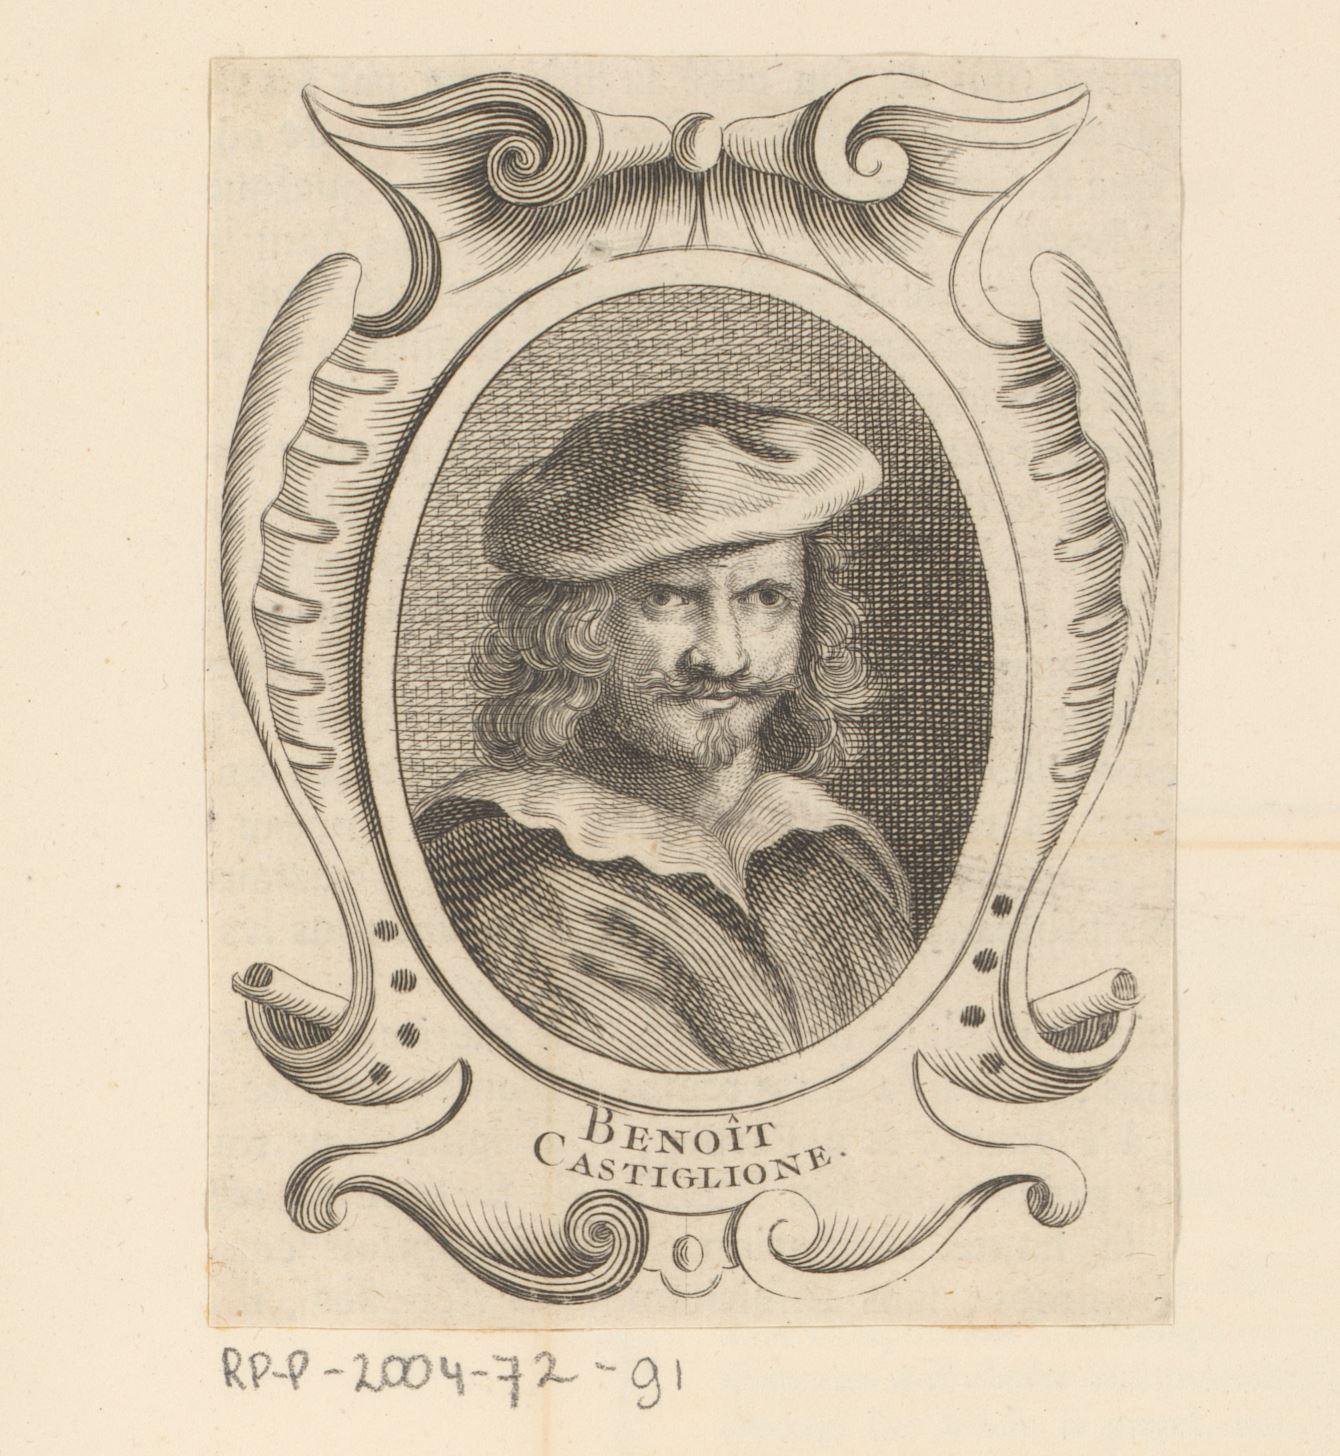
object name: print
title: Portret van Giovanni Benedetto Castiglione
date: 1745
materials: paper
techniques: engraving, letterpress printing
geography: paris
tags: print maker, draughtsman, giovanni benedetto castiglione, historical persons, portrait, self-portrait of painter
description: Prent uit: Dézallier d'Argenville, Antoine Joseph. Abrégé de la vie des plus fameux peintres. 4 dln. Parijs: De Bure l'aîné, 1745, dl. 1, p. 379. De samensteller heeft deze prent in het album geplakt als illustratie bij: Pilkington, Matthew en Johann Heinrich Füssli. A dictionary of painters, from the revival of the art to the present period. 4 dln. Londen: John Crowder, 1805, dl. 1, p. 114.